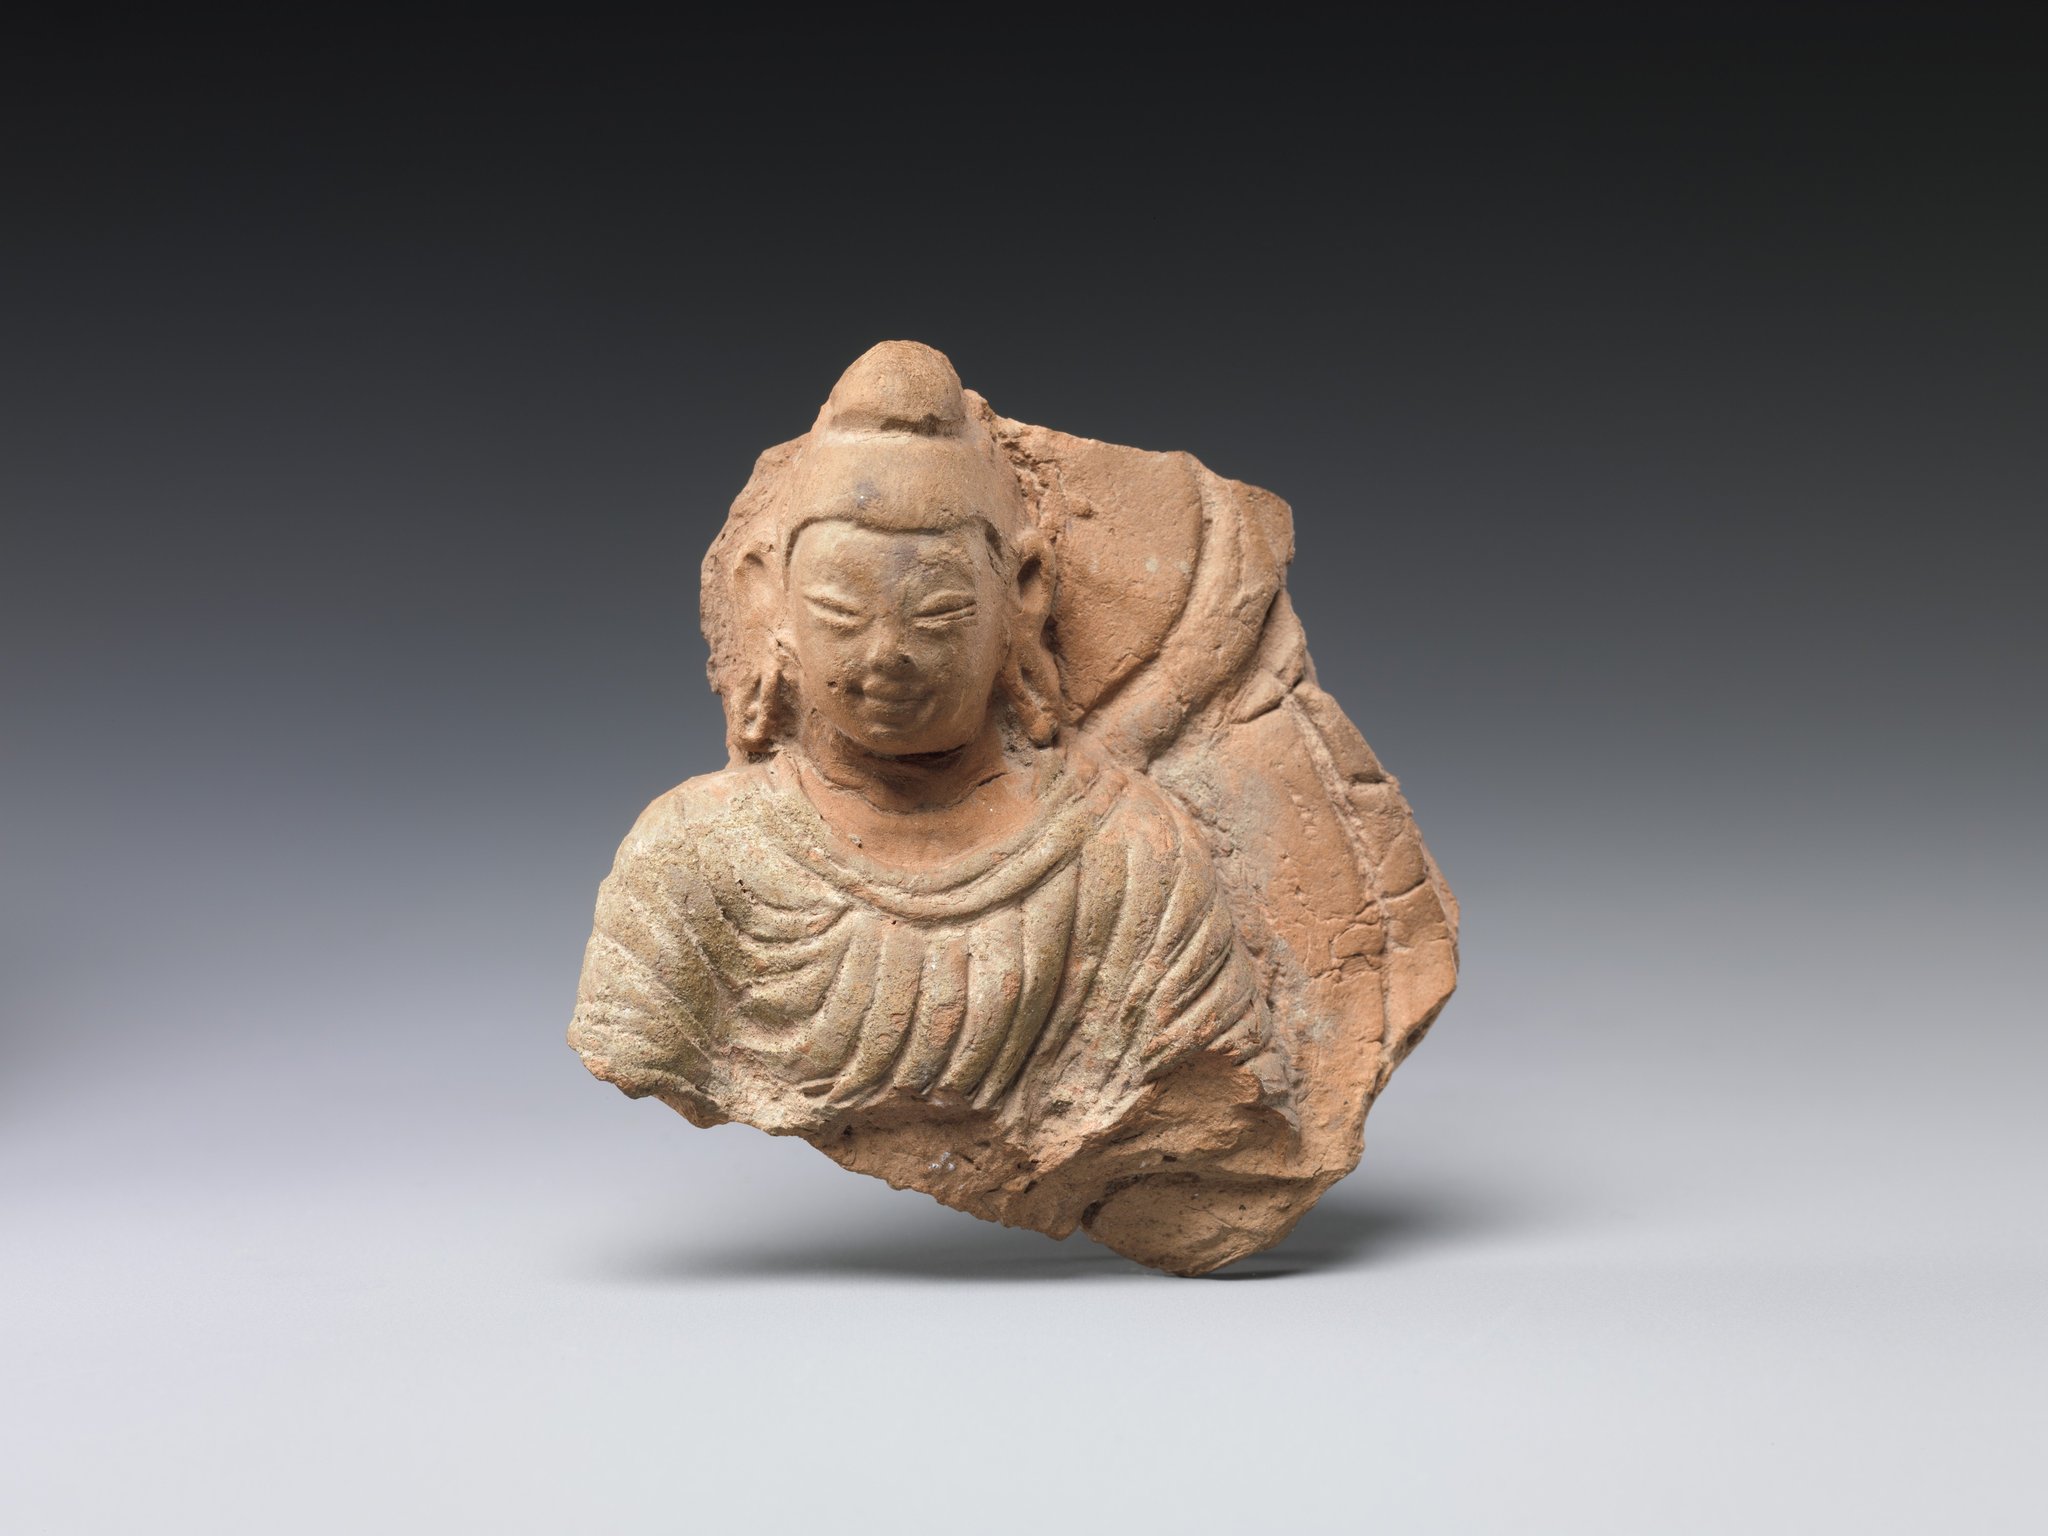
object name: plaque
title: Buddha with Halo and Mandorla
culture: chinese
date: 501-700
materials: terracotta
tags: buddhism,buddha